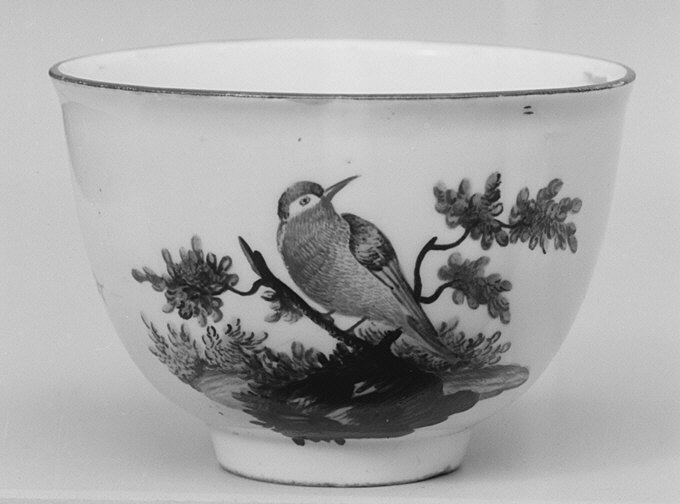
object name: cup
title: Cup (part of a service)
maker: frankenthal porcelain manufactory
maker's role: manufactory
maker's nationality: german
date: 1770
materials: hard paste porcelain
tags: birds,trees